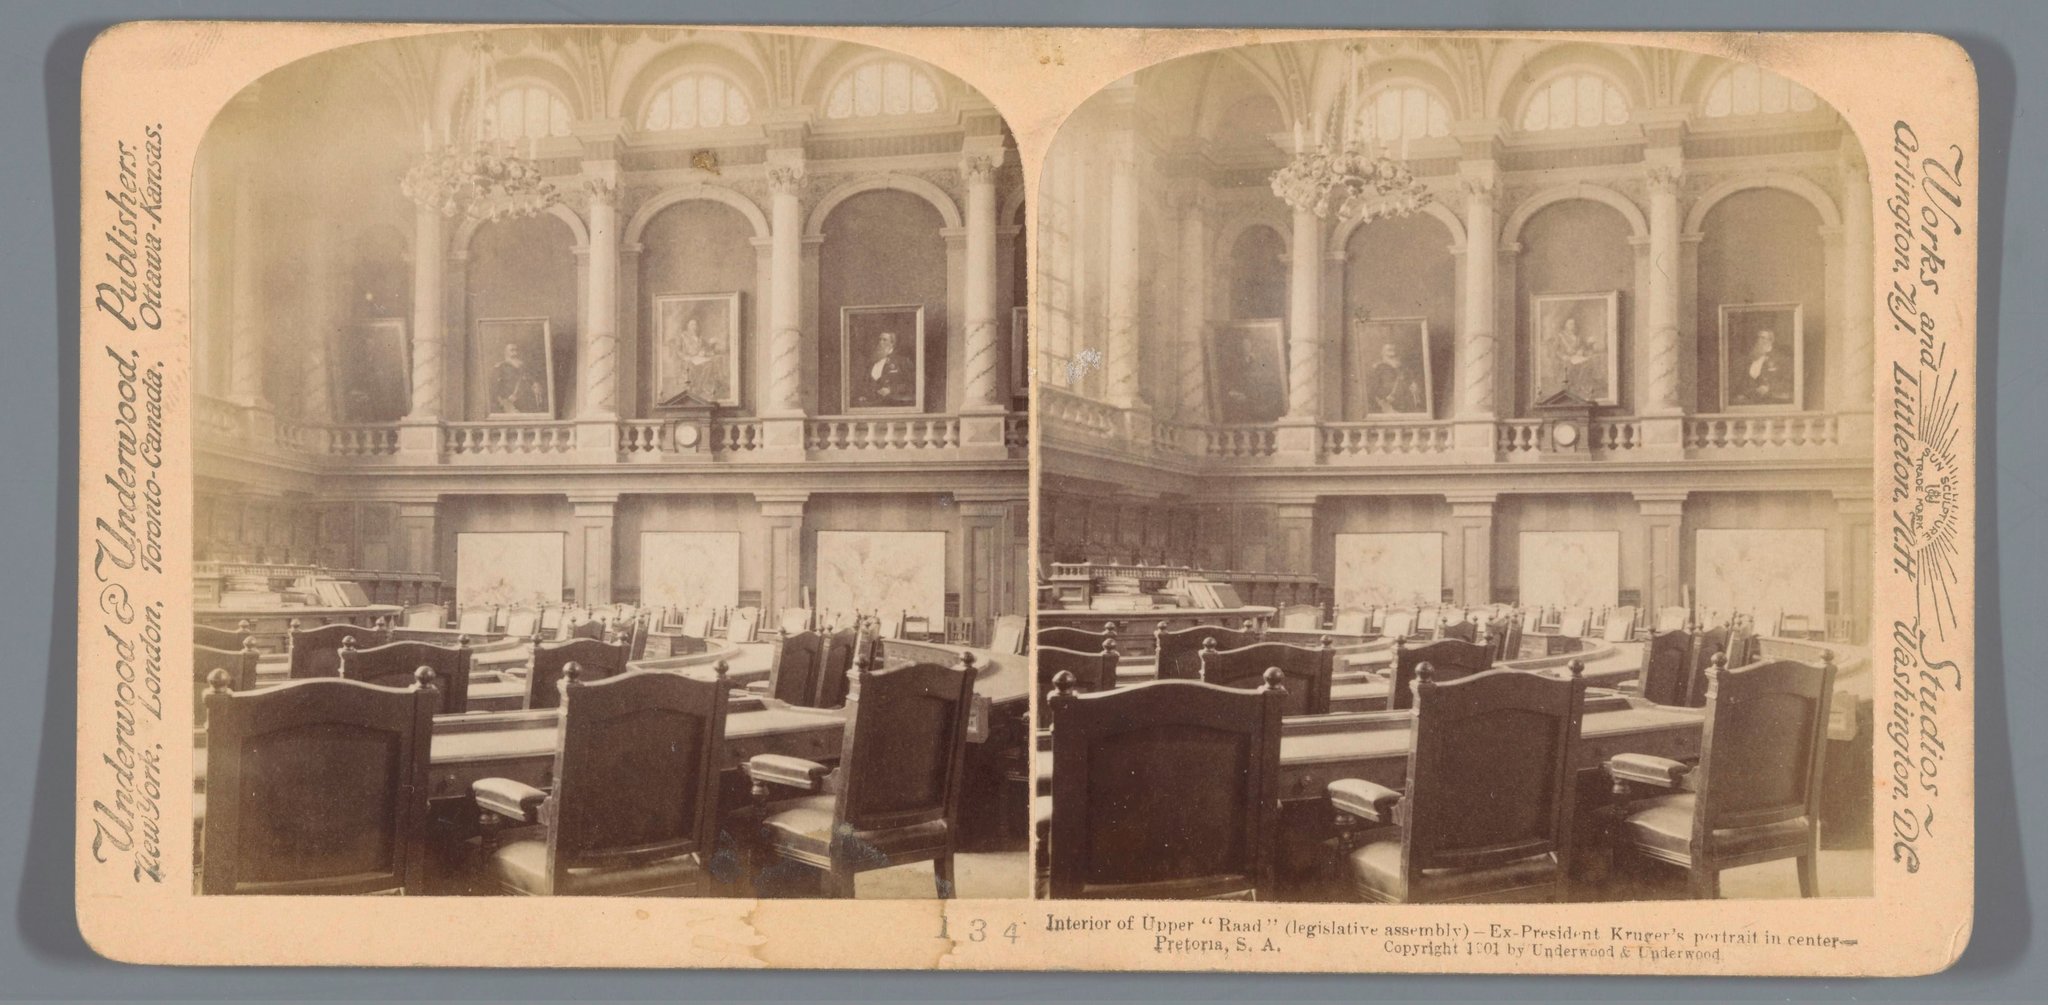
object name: stereograph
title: Gezicht op het interieur van de wetgevende vergadering in Pretoria, Zuid-Afrika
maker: Anonymous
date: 1901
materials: cardboard, paper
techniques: albumen print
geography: pretoria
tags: lower house, parliament, chamber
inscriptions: copyright notice: ‘Copyright 1901 by Underwood & Underwood.’, inscription: ‘Works and Studios ~/ Arlington, N.J. Littleton, N.H. Washington, D.C.’, inscription, number: ‘134’